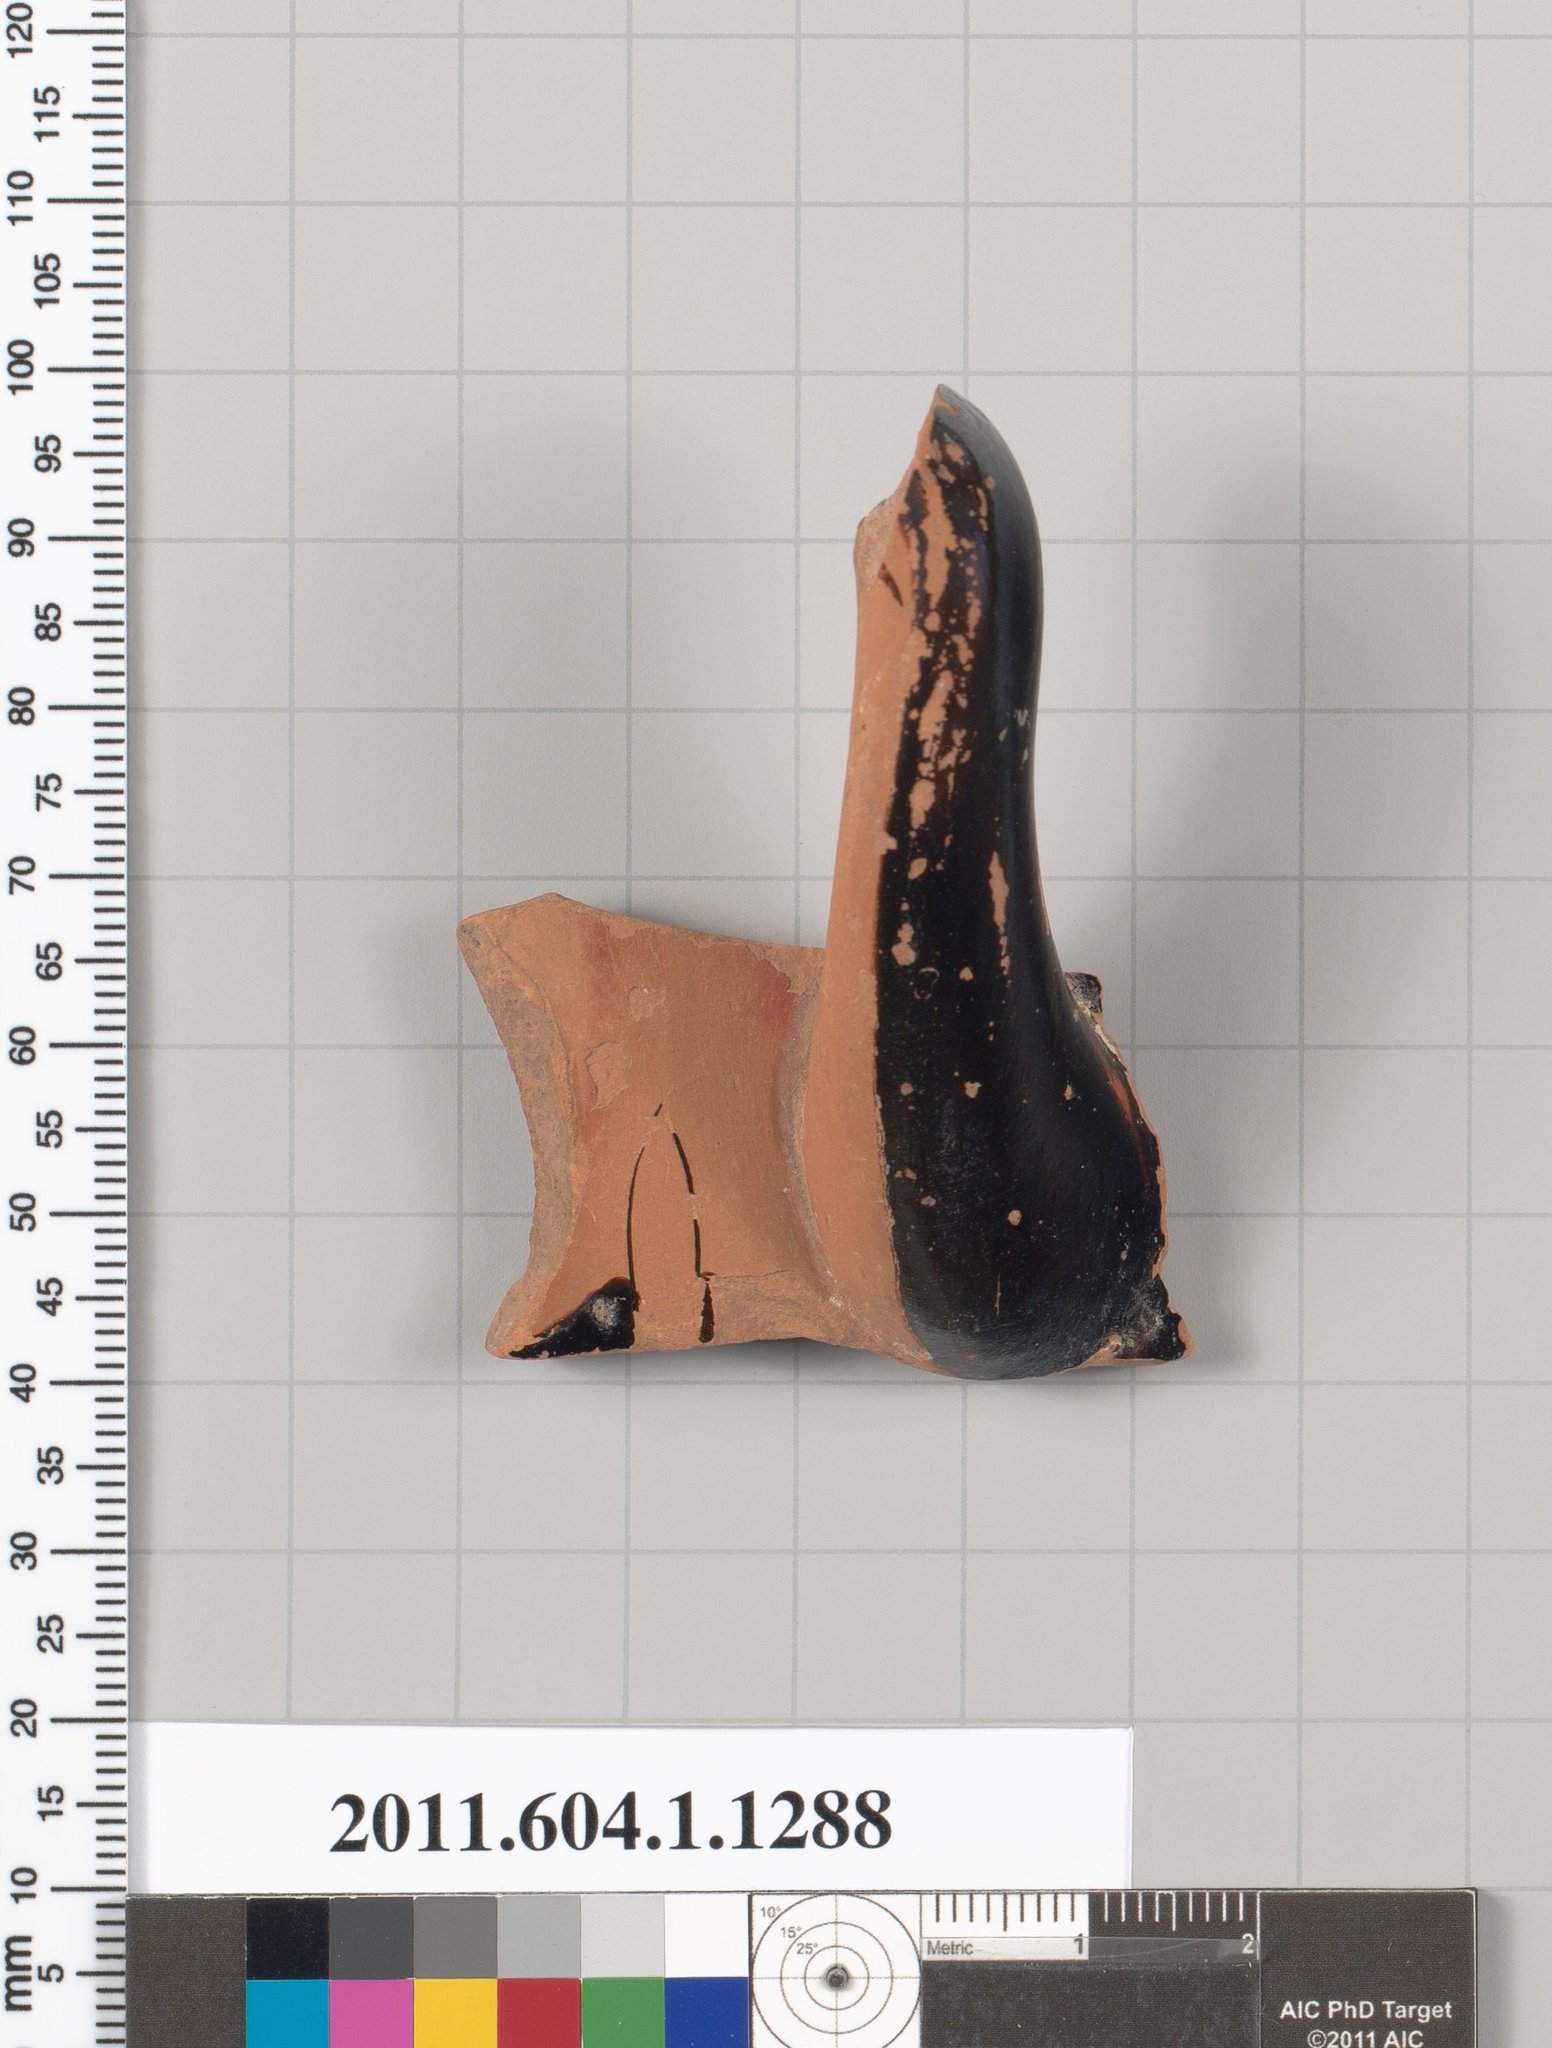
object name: kylix fragment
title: Terracotta fragment of a kylix (drinking cup)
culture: greek, attic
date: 500-401 BCE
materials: terracotta